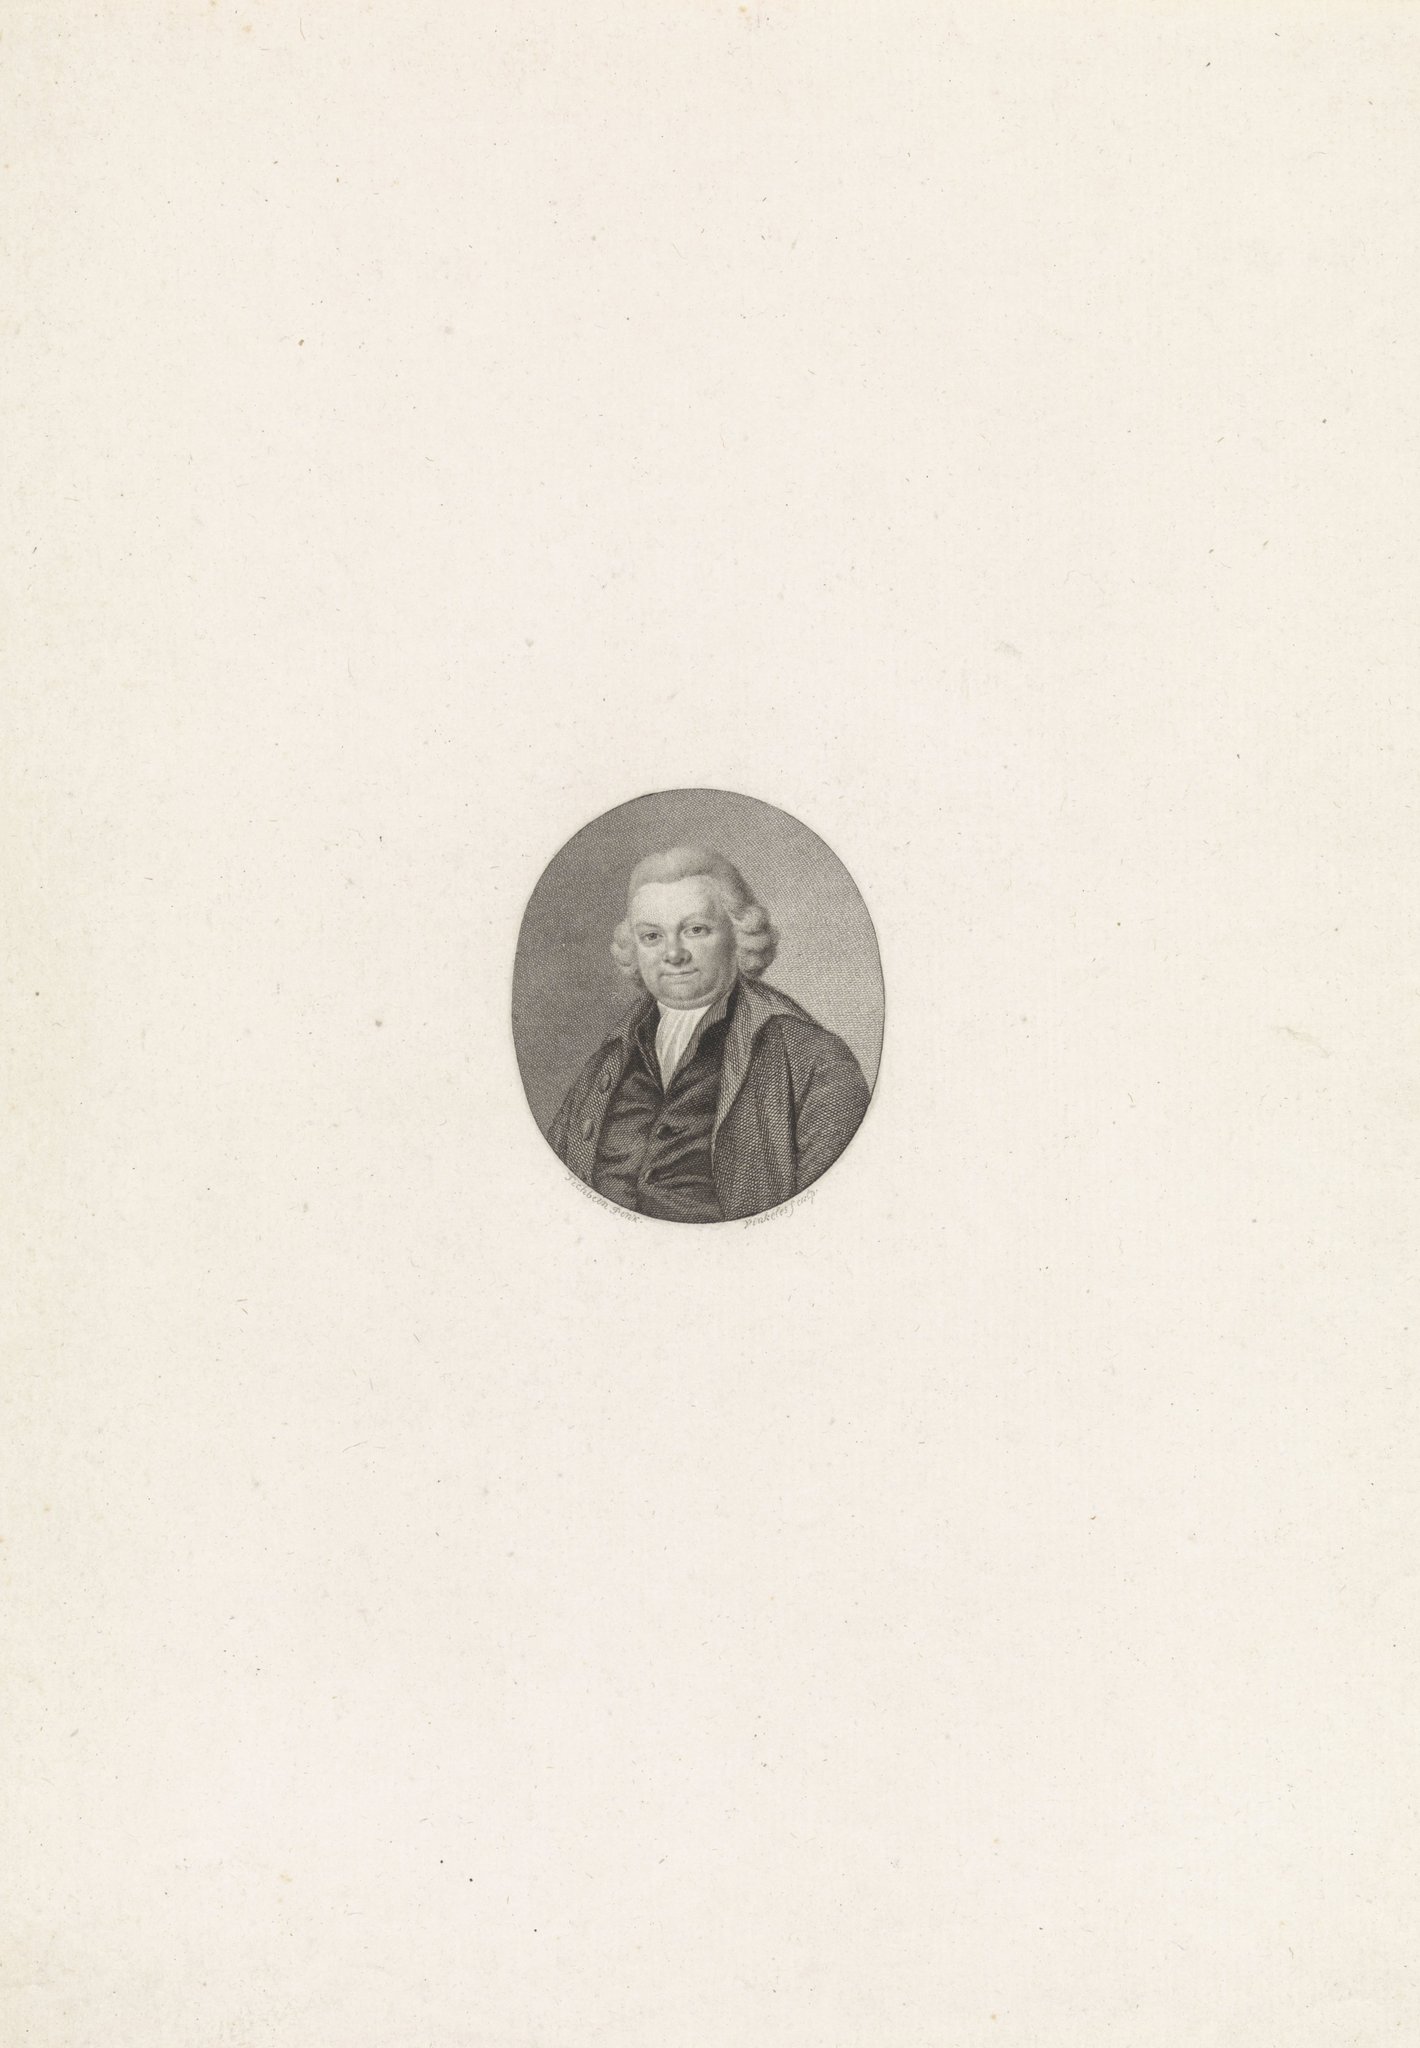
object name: print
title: Portret van Jeronimo de Bosch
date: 1808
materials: paper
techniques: etching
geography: amsterdam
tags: amsterdam, jeronimo de bosch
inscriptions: collector's mark: Lugt 2228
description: Latere staat prent gebruikt als titelpagina voor: Bosch, Jeronimo de. Poëmata. Utrecht: B. Wild en J. Altheer, 1808.